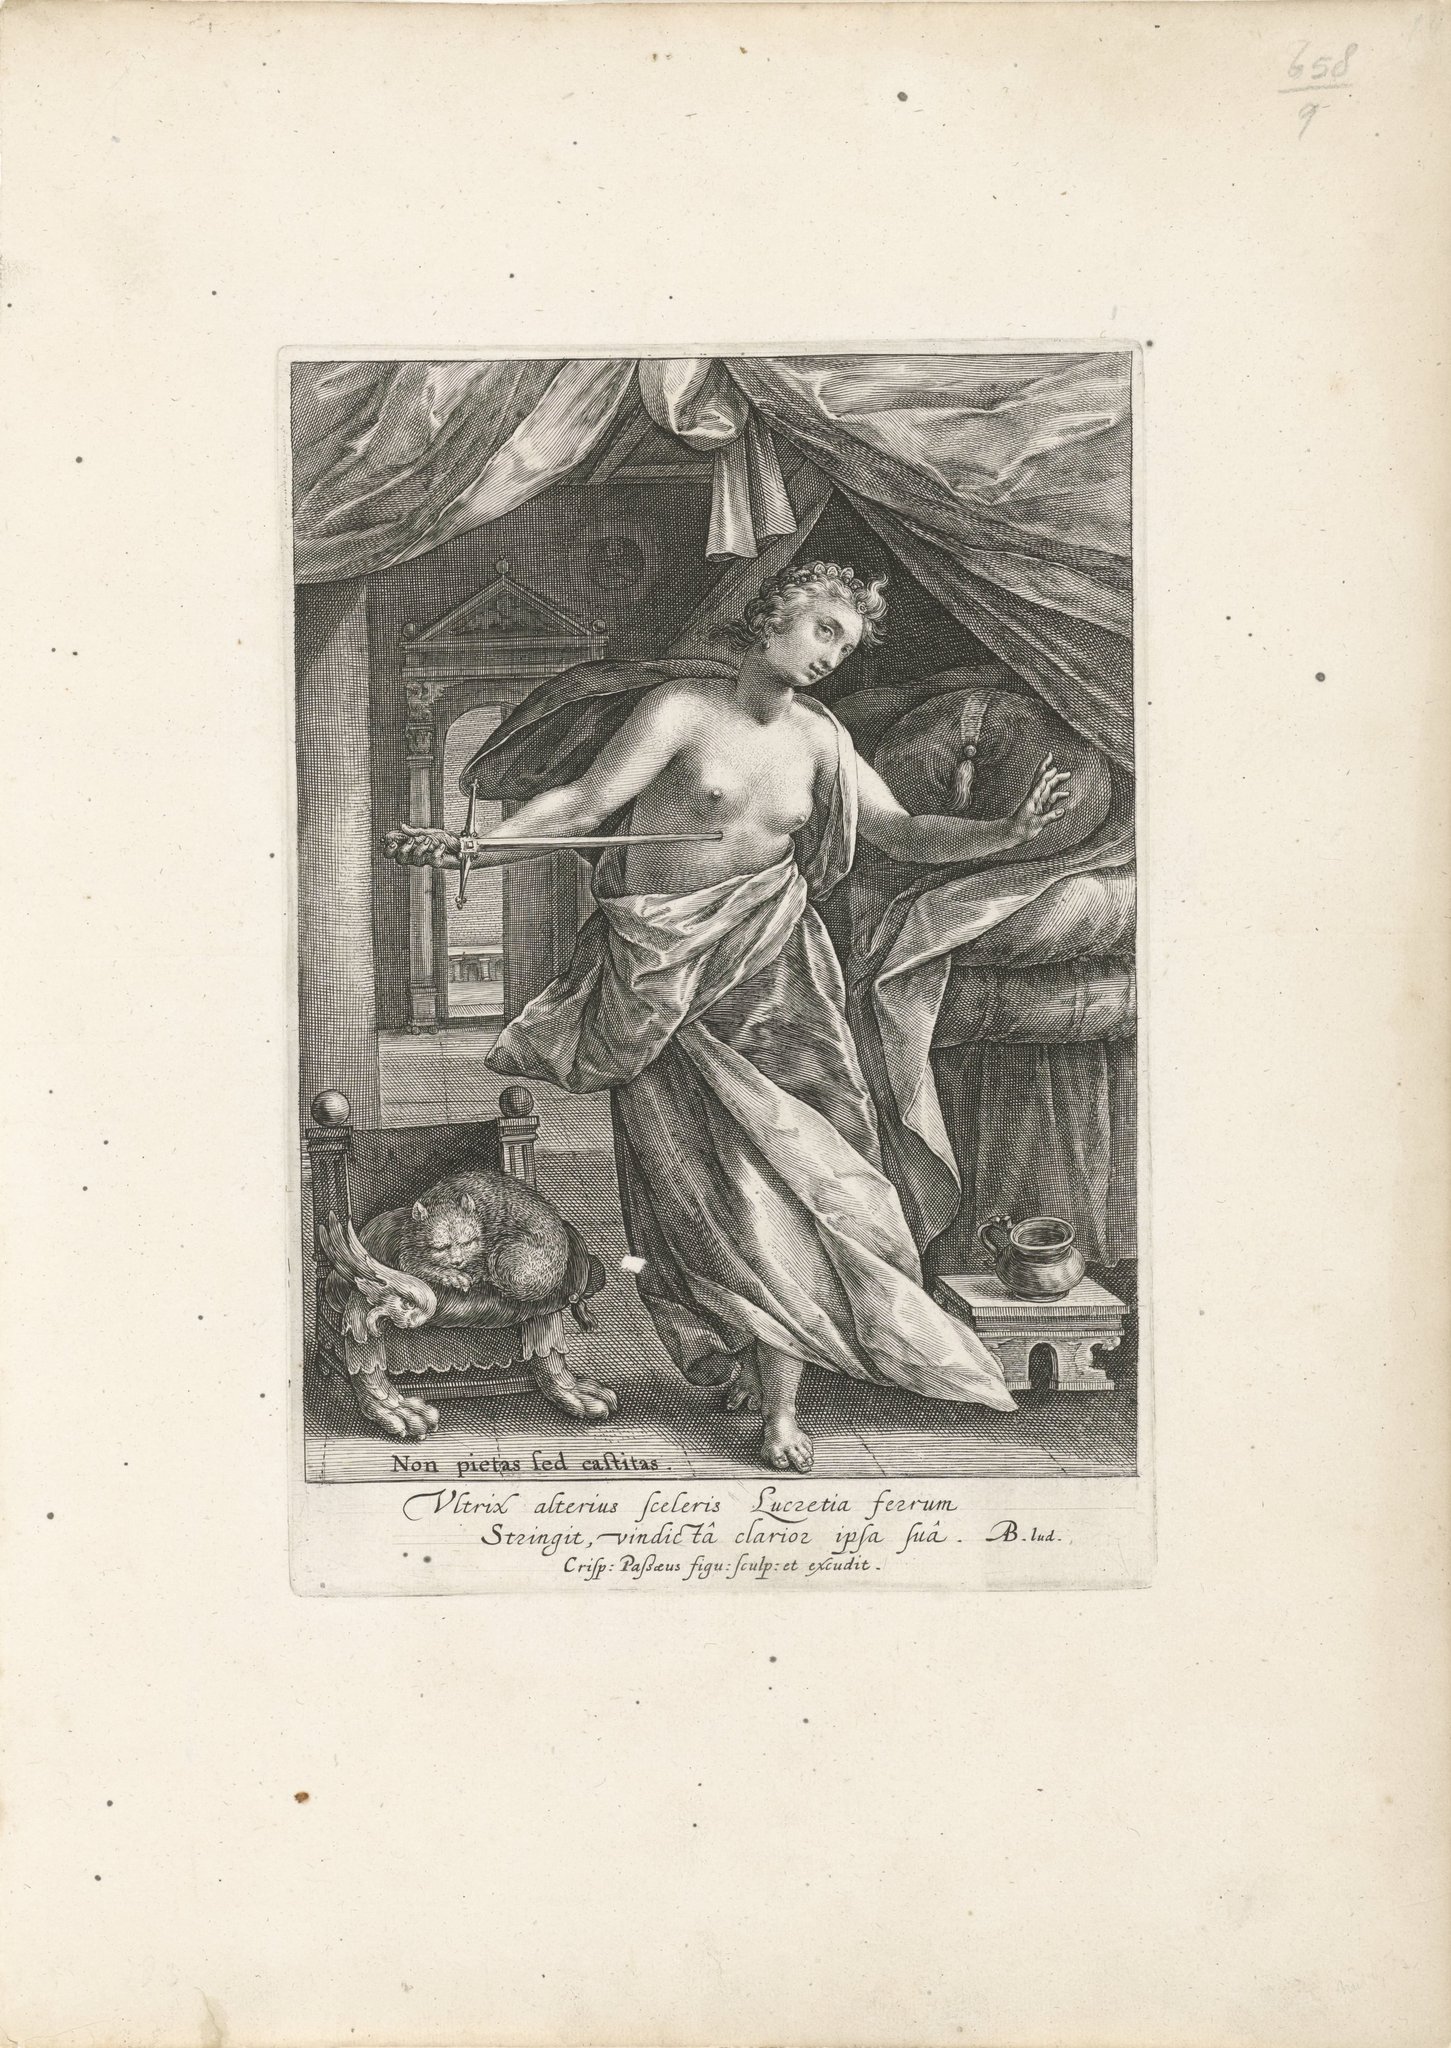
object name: print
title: Lucretia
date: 1574-1637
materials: paper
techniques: engraving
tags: death of lucretia: she commits suicide by stabbing herself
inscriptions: collector's mark: Lugt 2760, collector's mark: Lugt 2228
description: Interieur met Lucretia die op het punt staat zich te doorsteken met een dolk. Linksonder een motto in het Latijn dat verwijst naar haar deugdzaamheid. In de marge een tweeregelig onderschrift in het Latijn.